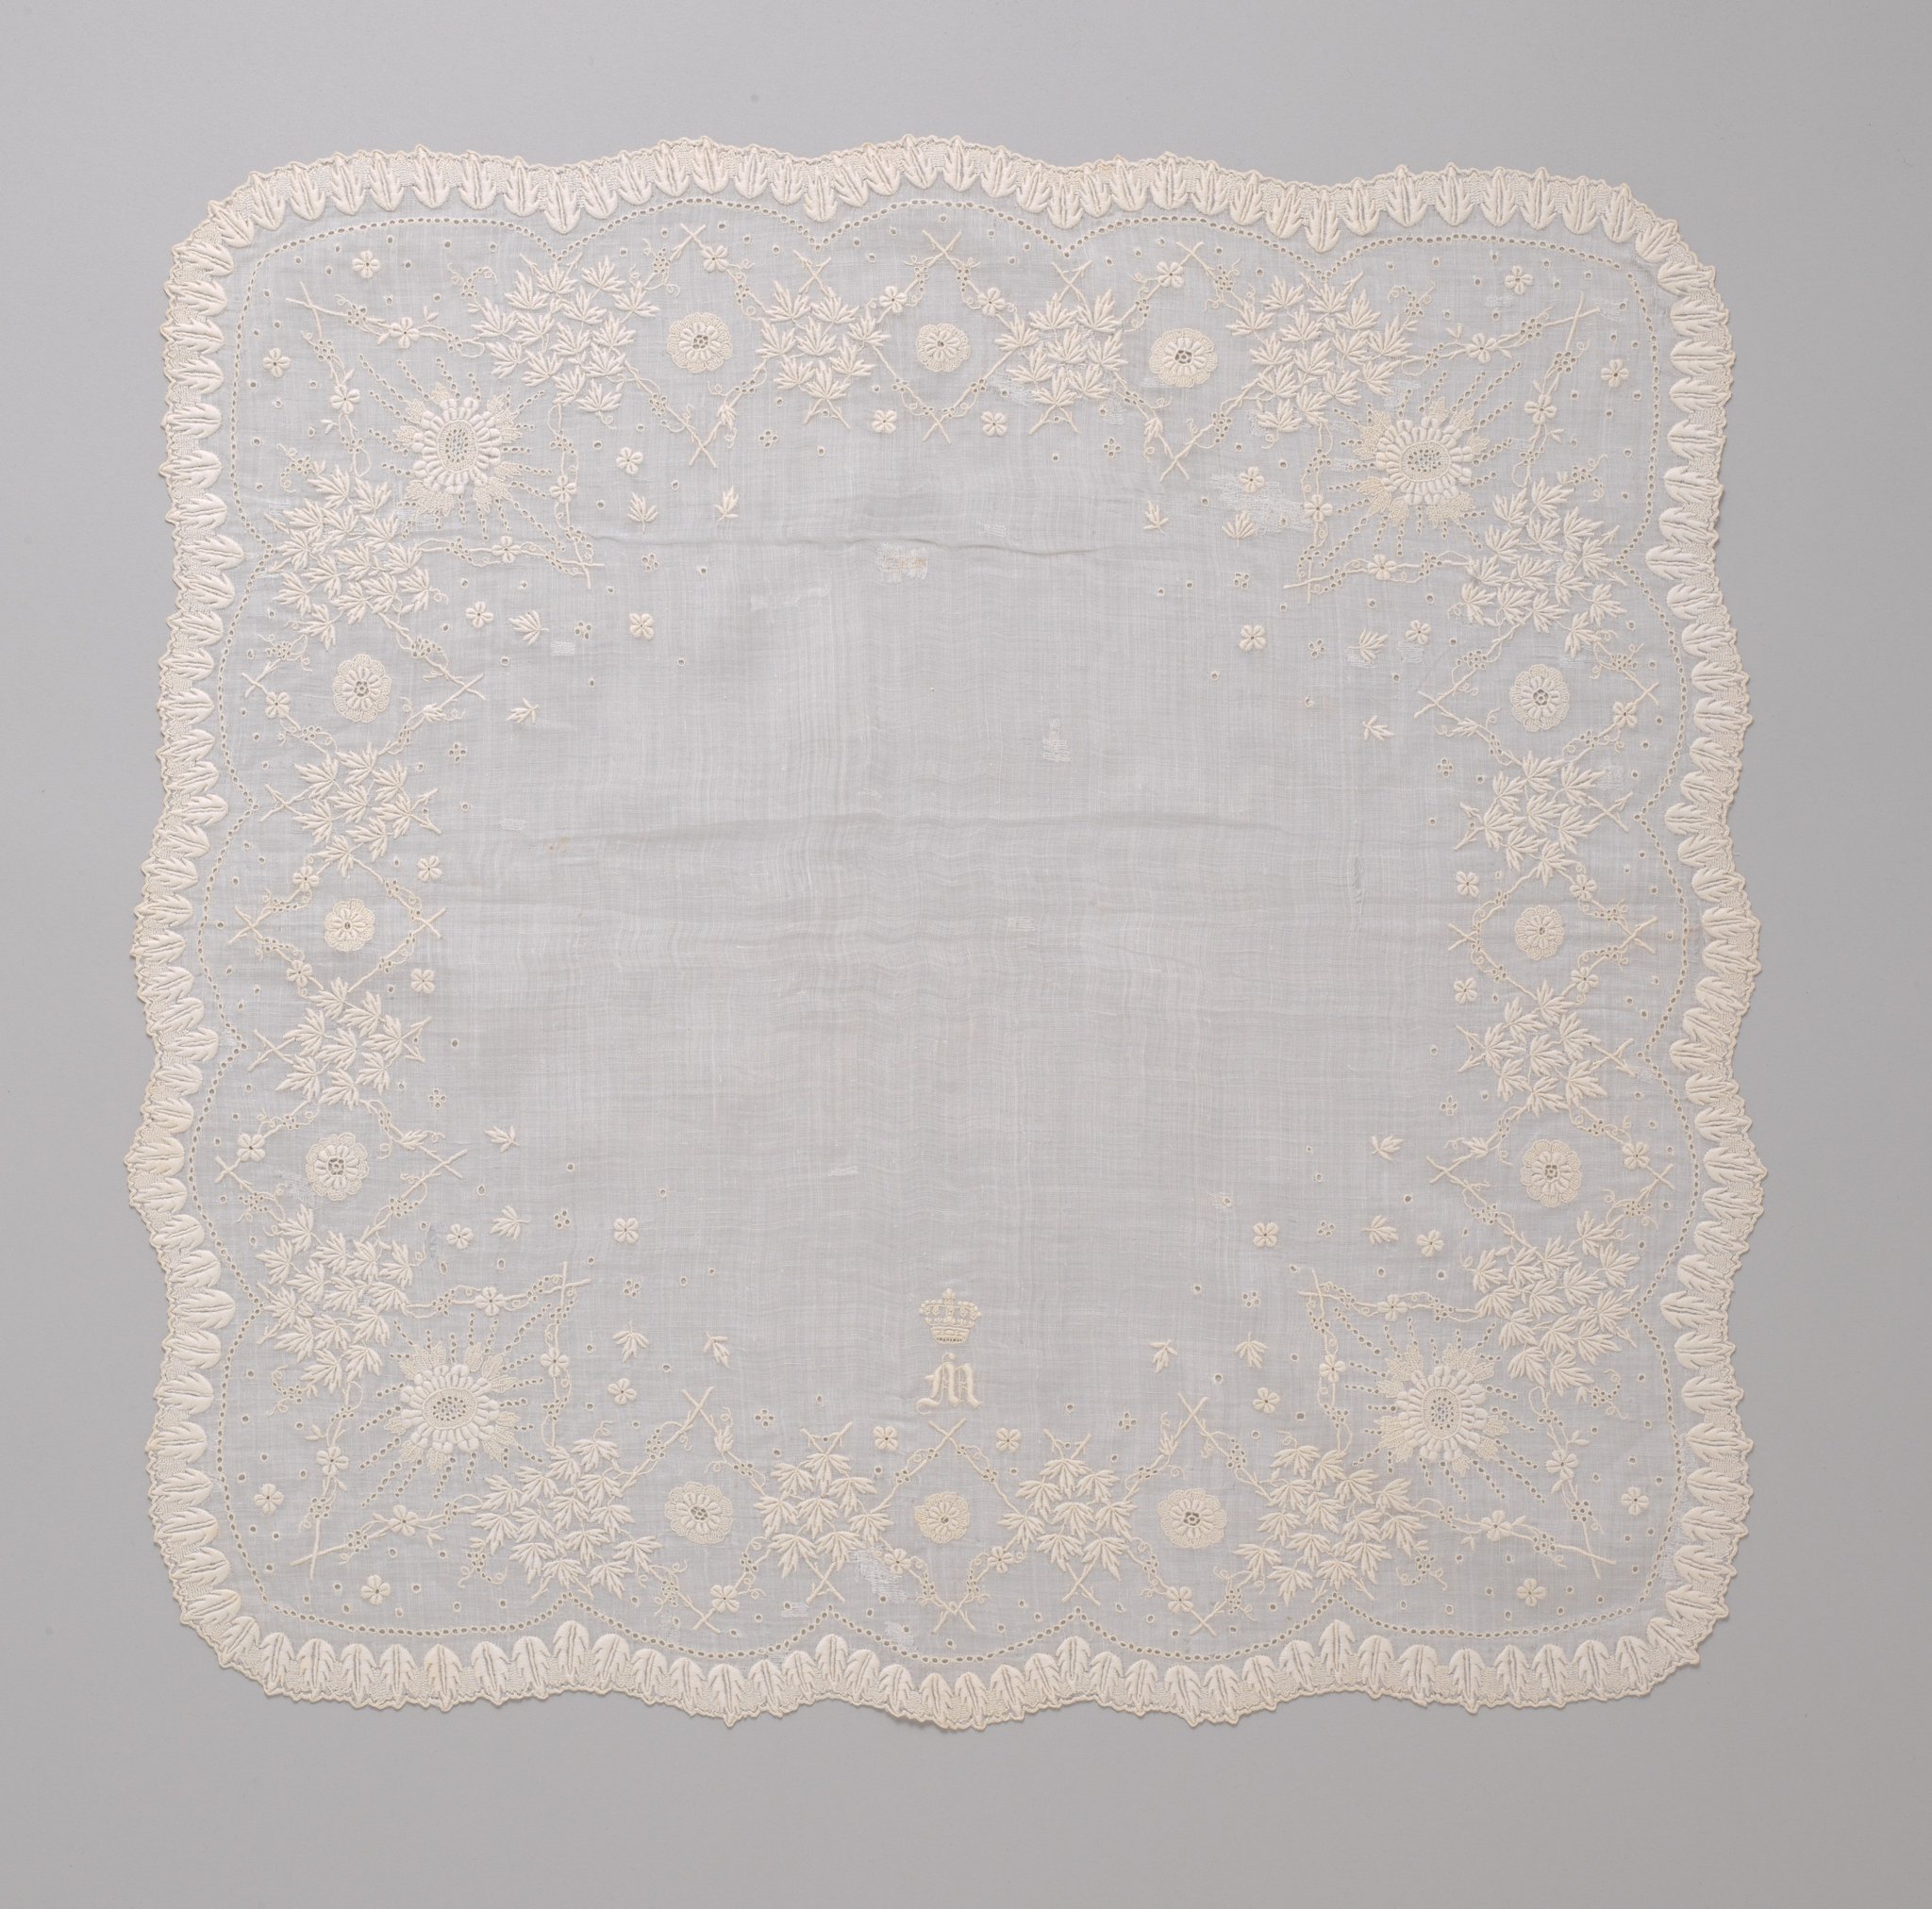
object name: handkerchief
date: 1840-1880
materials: linen, silk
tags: flowers